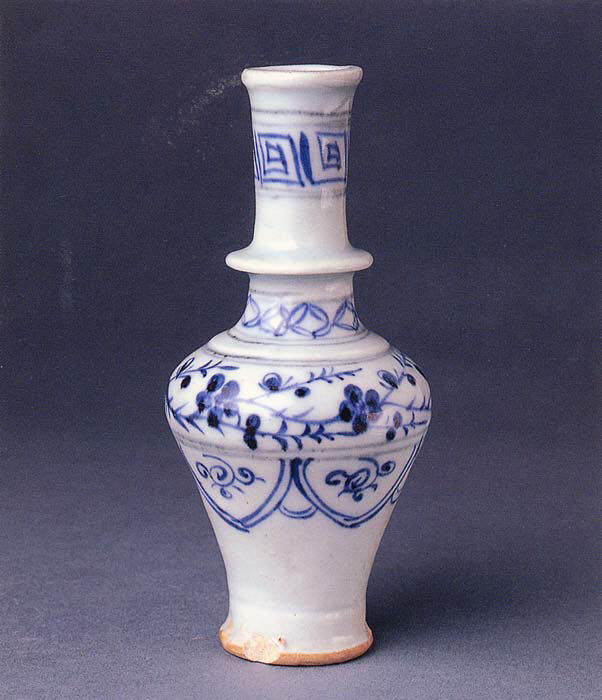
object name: vase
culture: chinese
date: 1367-1400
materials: porcelain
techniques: painting, underglaze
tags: flowers,leaves